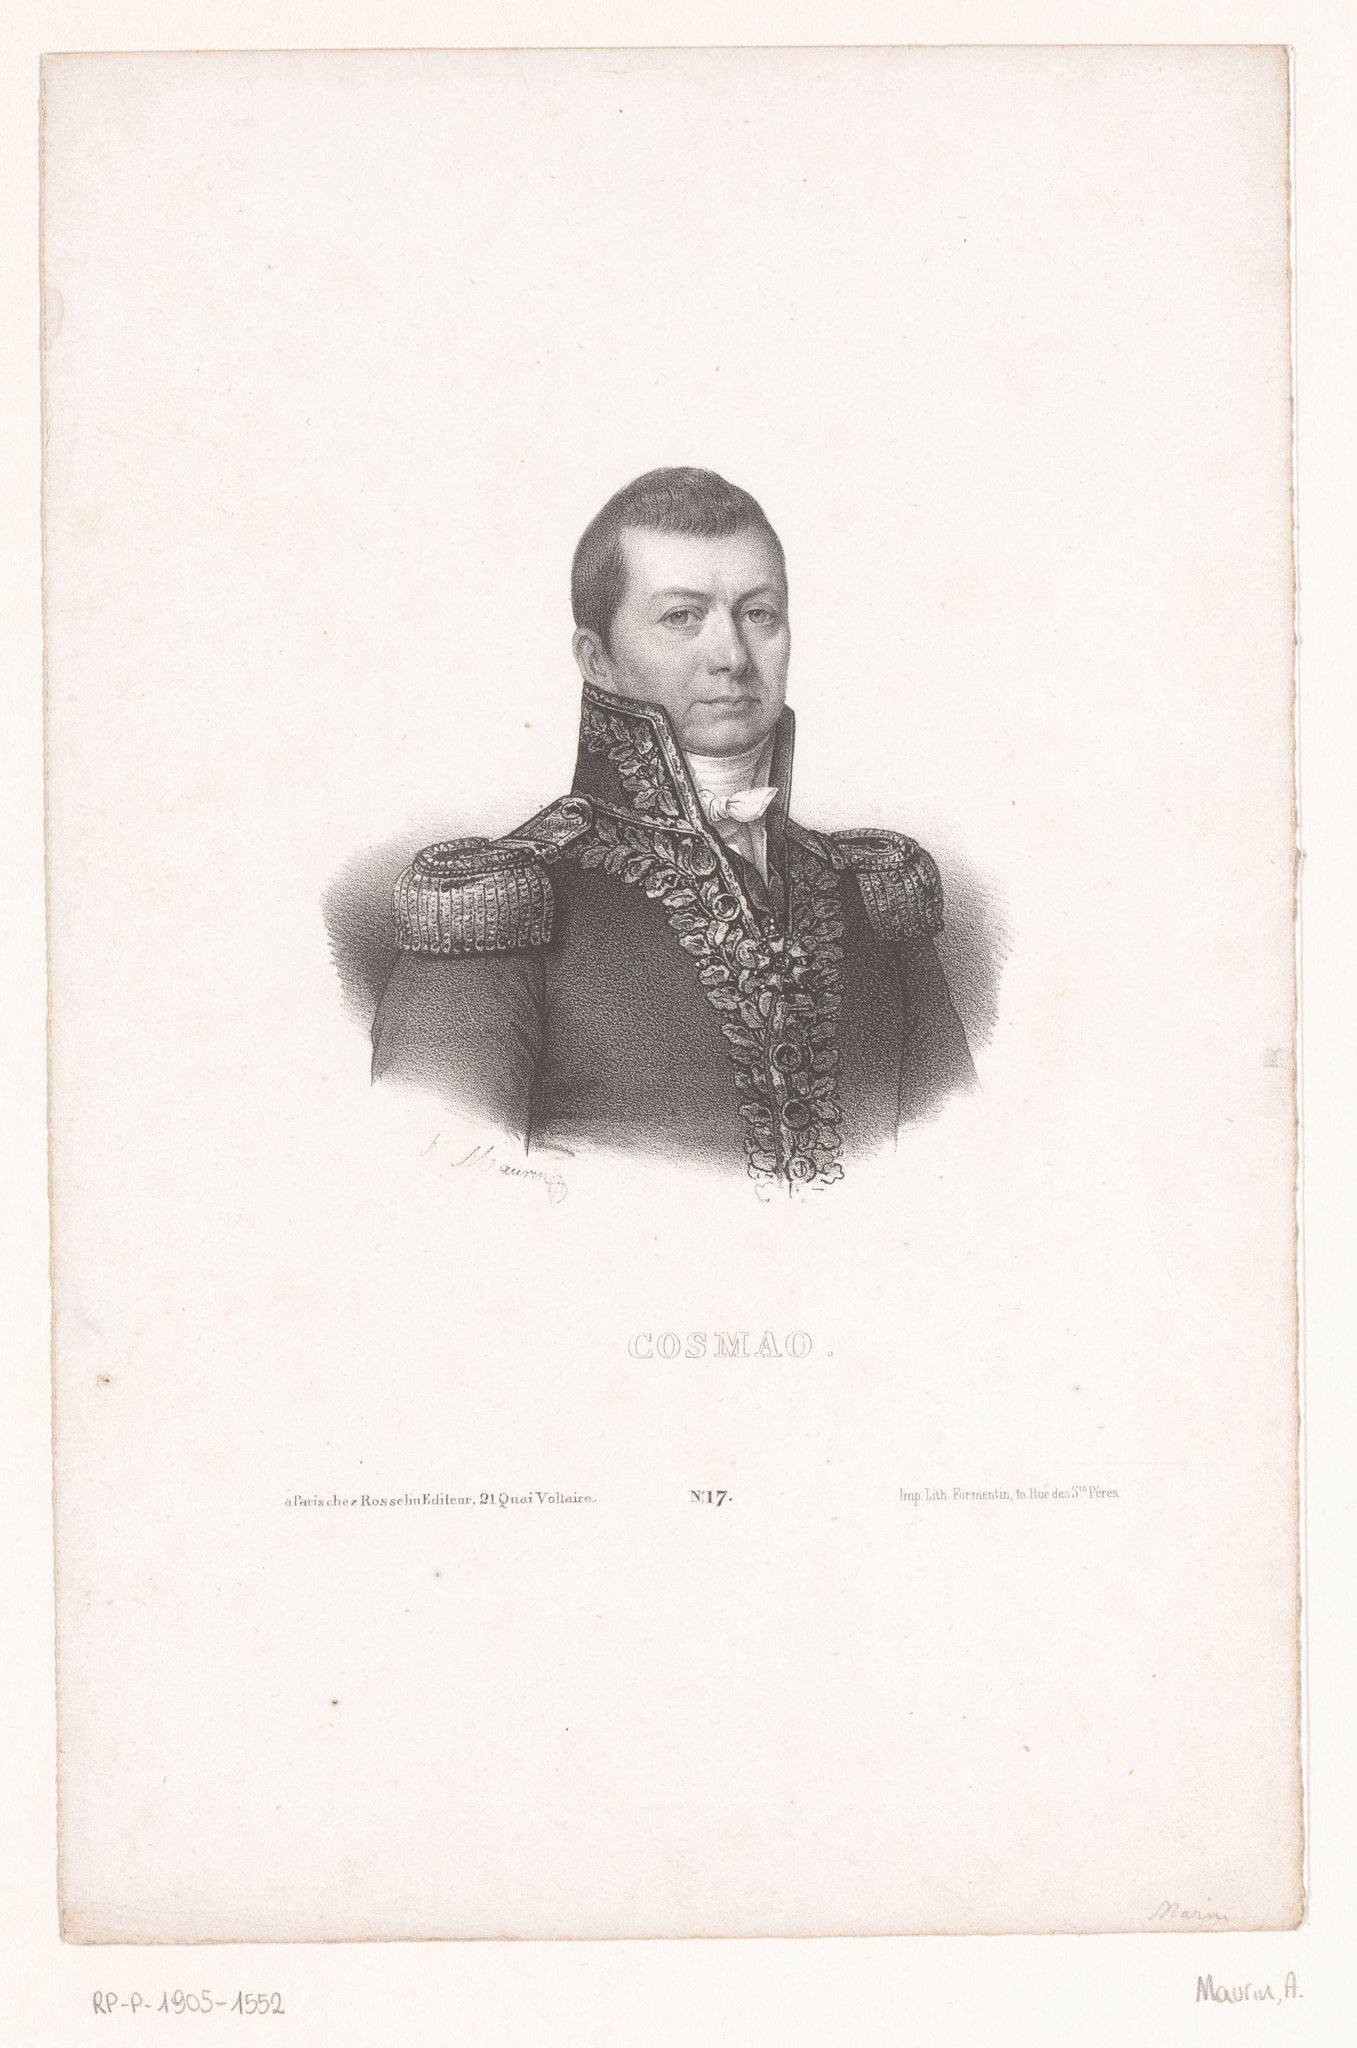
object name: print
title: Cosmao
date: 1835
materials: paper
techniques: lithograph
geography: paris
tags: historical persons, officer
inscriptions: collector's mark: Lugt 2228